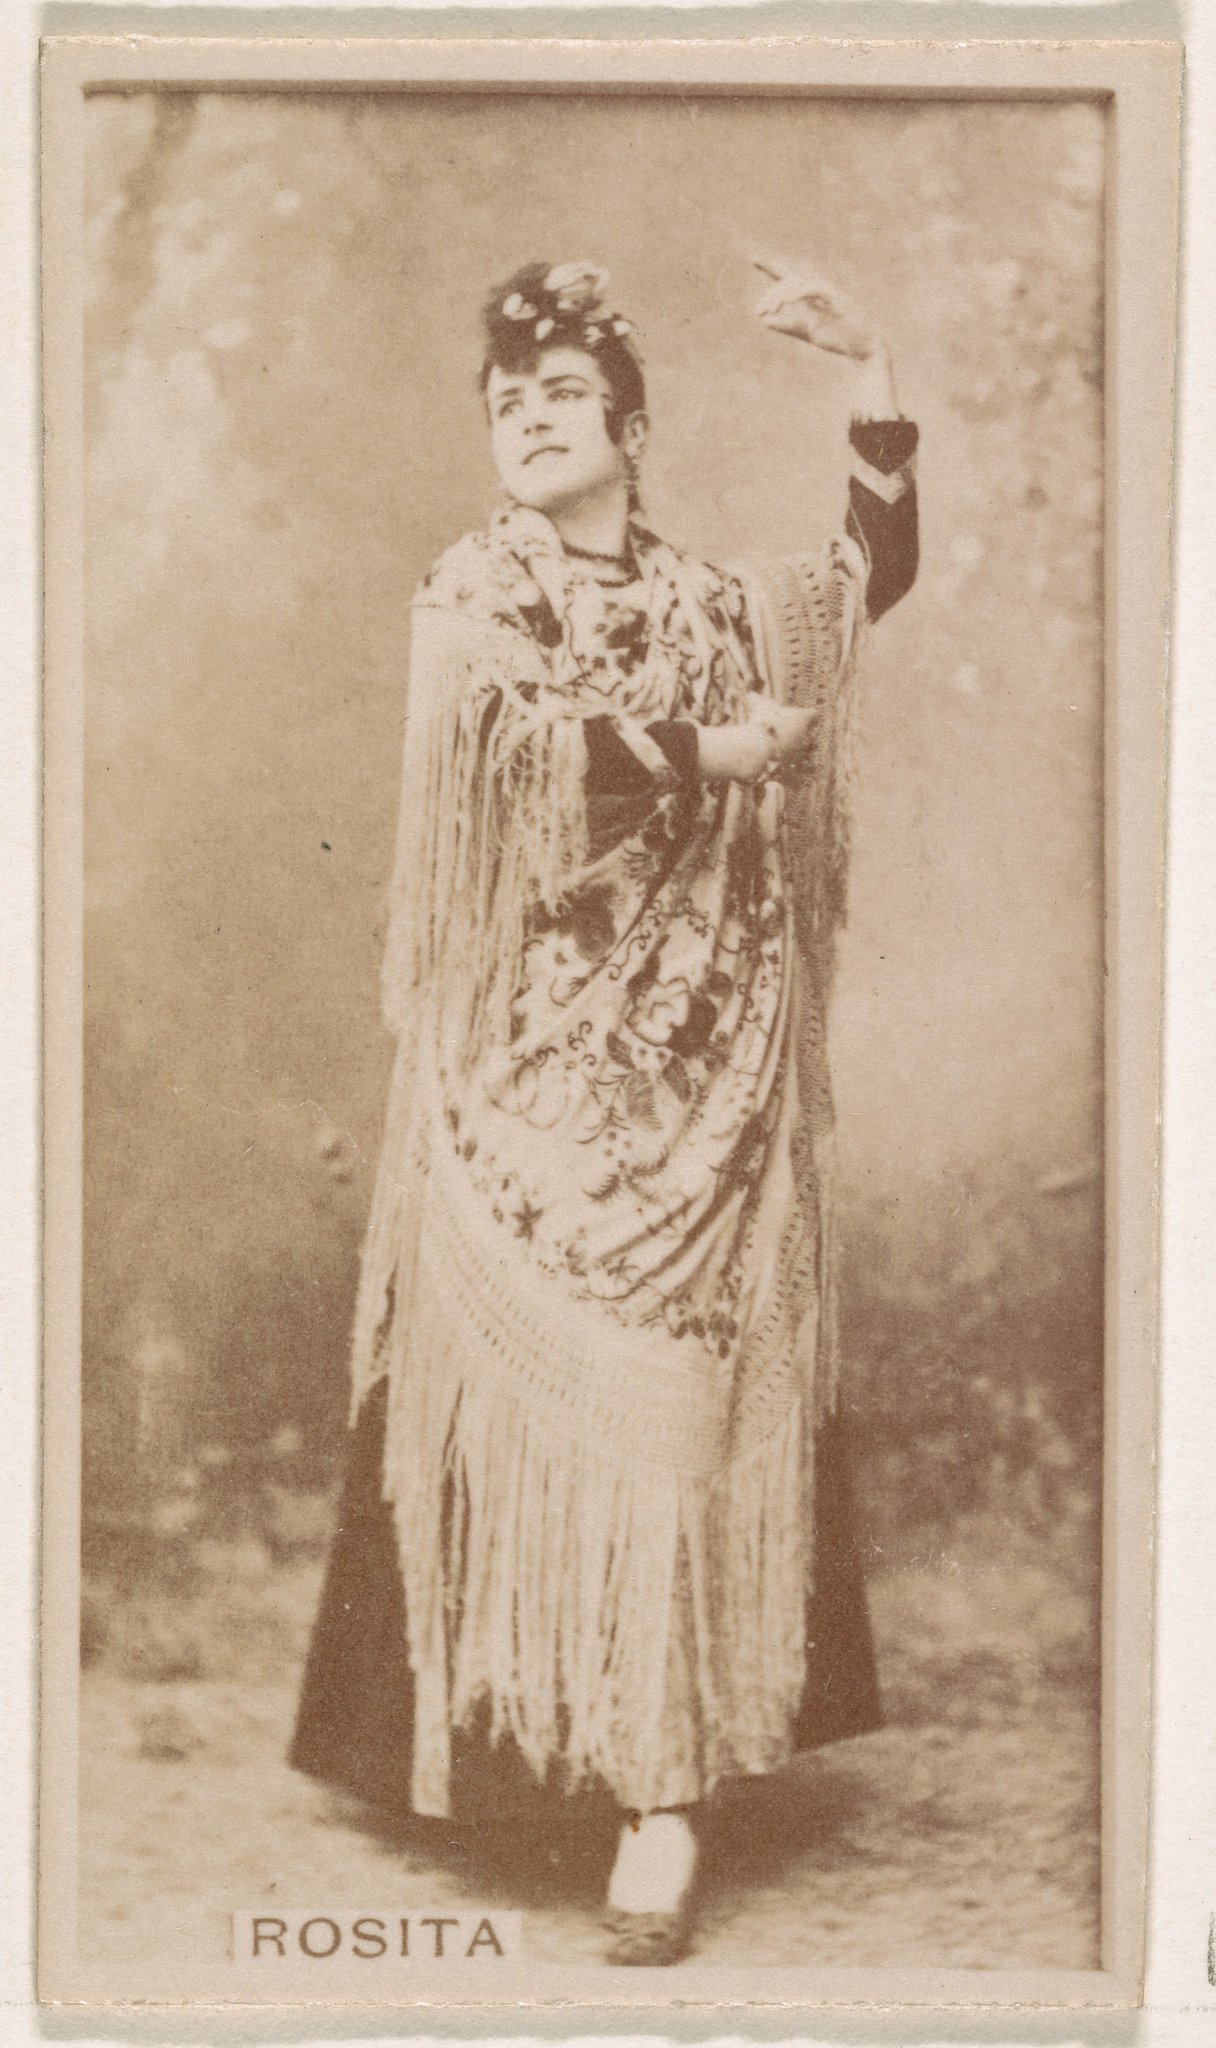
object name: photograph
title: Rosita, from the Actresses series (N245) issued by Kinney Brothers to promote Sweet Caporal Cigarettes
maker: kinney brothers tobacco company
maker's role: publisher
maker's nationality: american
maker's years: 1869-2011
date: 1890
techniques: albumen silver print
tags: portraits,women,actresses